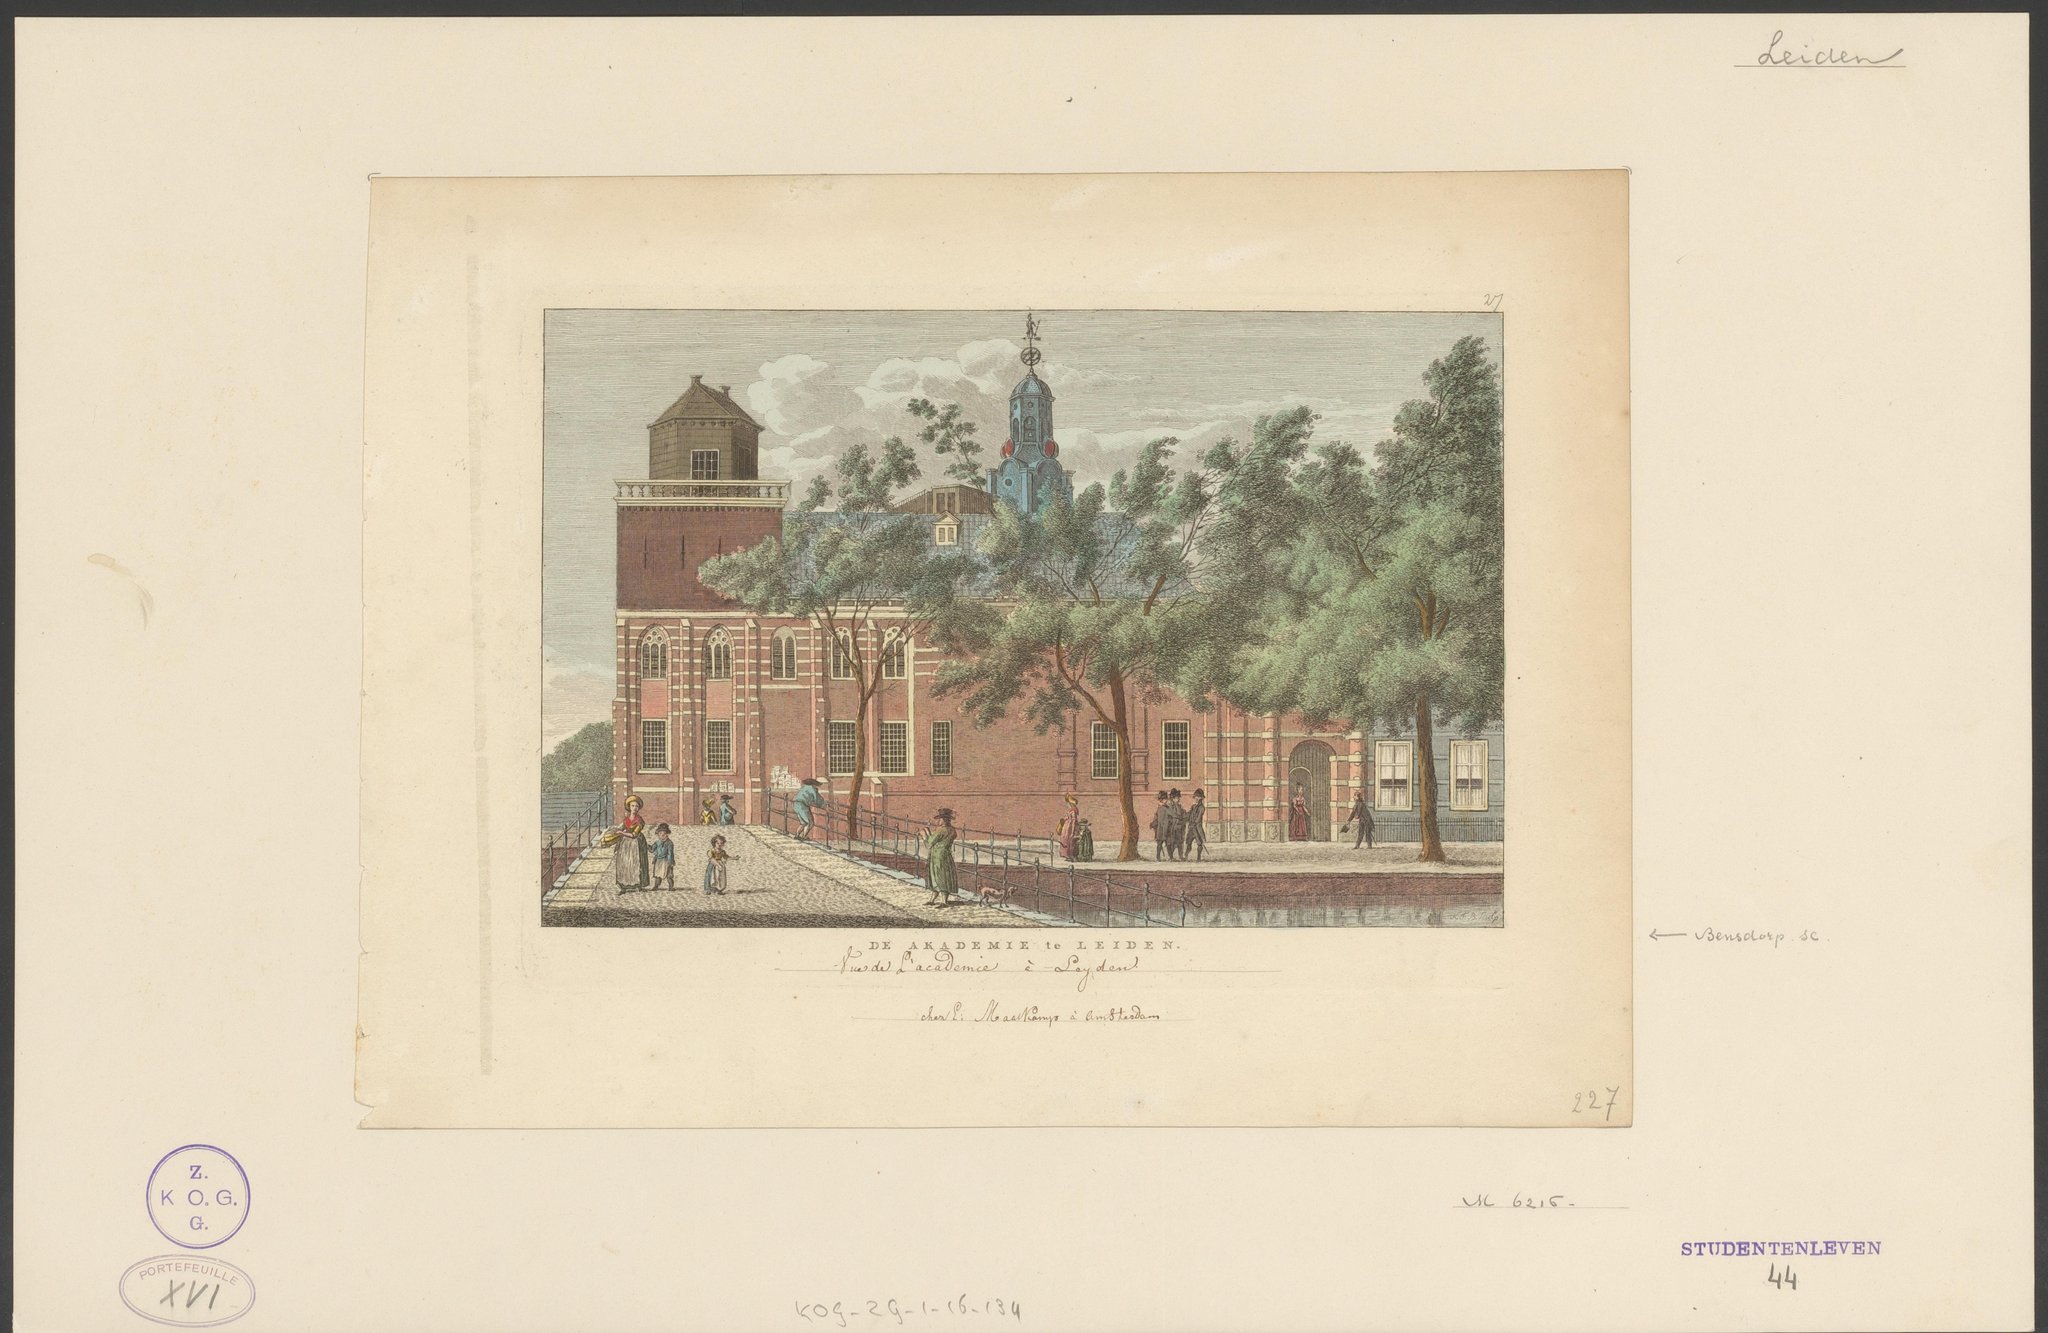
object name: print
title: De akademie te Leiden / Vue de L'academie à Leyden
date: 1786-1792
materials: paper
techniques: engraving, etching, hand coloring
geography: amsterdam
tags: university building, college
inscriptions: stamp, stamp, collector's mark: Lugt 1641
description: Huidige staat van prent uitgegeven als onderdeel van een plaatwerk uit ca. 1824-1825 met 74 (ongenummerde) platen van de belangrijkste topografische gezichten en verschillende zeden en gewoonten in het Verenigd Koninkrijk der Nederlanden, getiteld 'Tableau des principales vues des palais et édifices : représentations et des coutumes et usages, dans les provinces septentrionales du Royaume des Pays-Bas'. Eerdere staat gebruikt in: Vaderlandsche gezichten, of afbeeldingen van den tegenwoordigen staat der Vereenigde Nederlanden (…). Amsterdam: Hendrik Gartman, Willem Vermandel en Jan Willem Smit, 1786-1792. Uitgegeven in afleveringen met ieder een eigen bifolium en inhoudsopgave. Alle prenten in deze publicatie zijn gegraveerd door Carel Frederik Bendorp (I) en, in de meeste gevallen, gebaseerd op tekeningen van Jan Bulthuis.